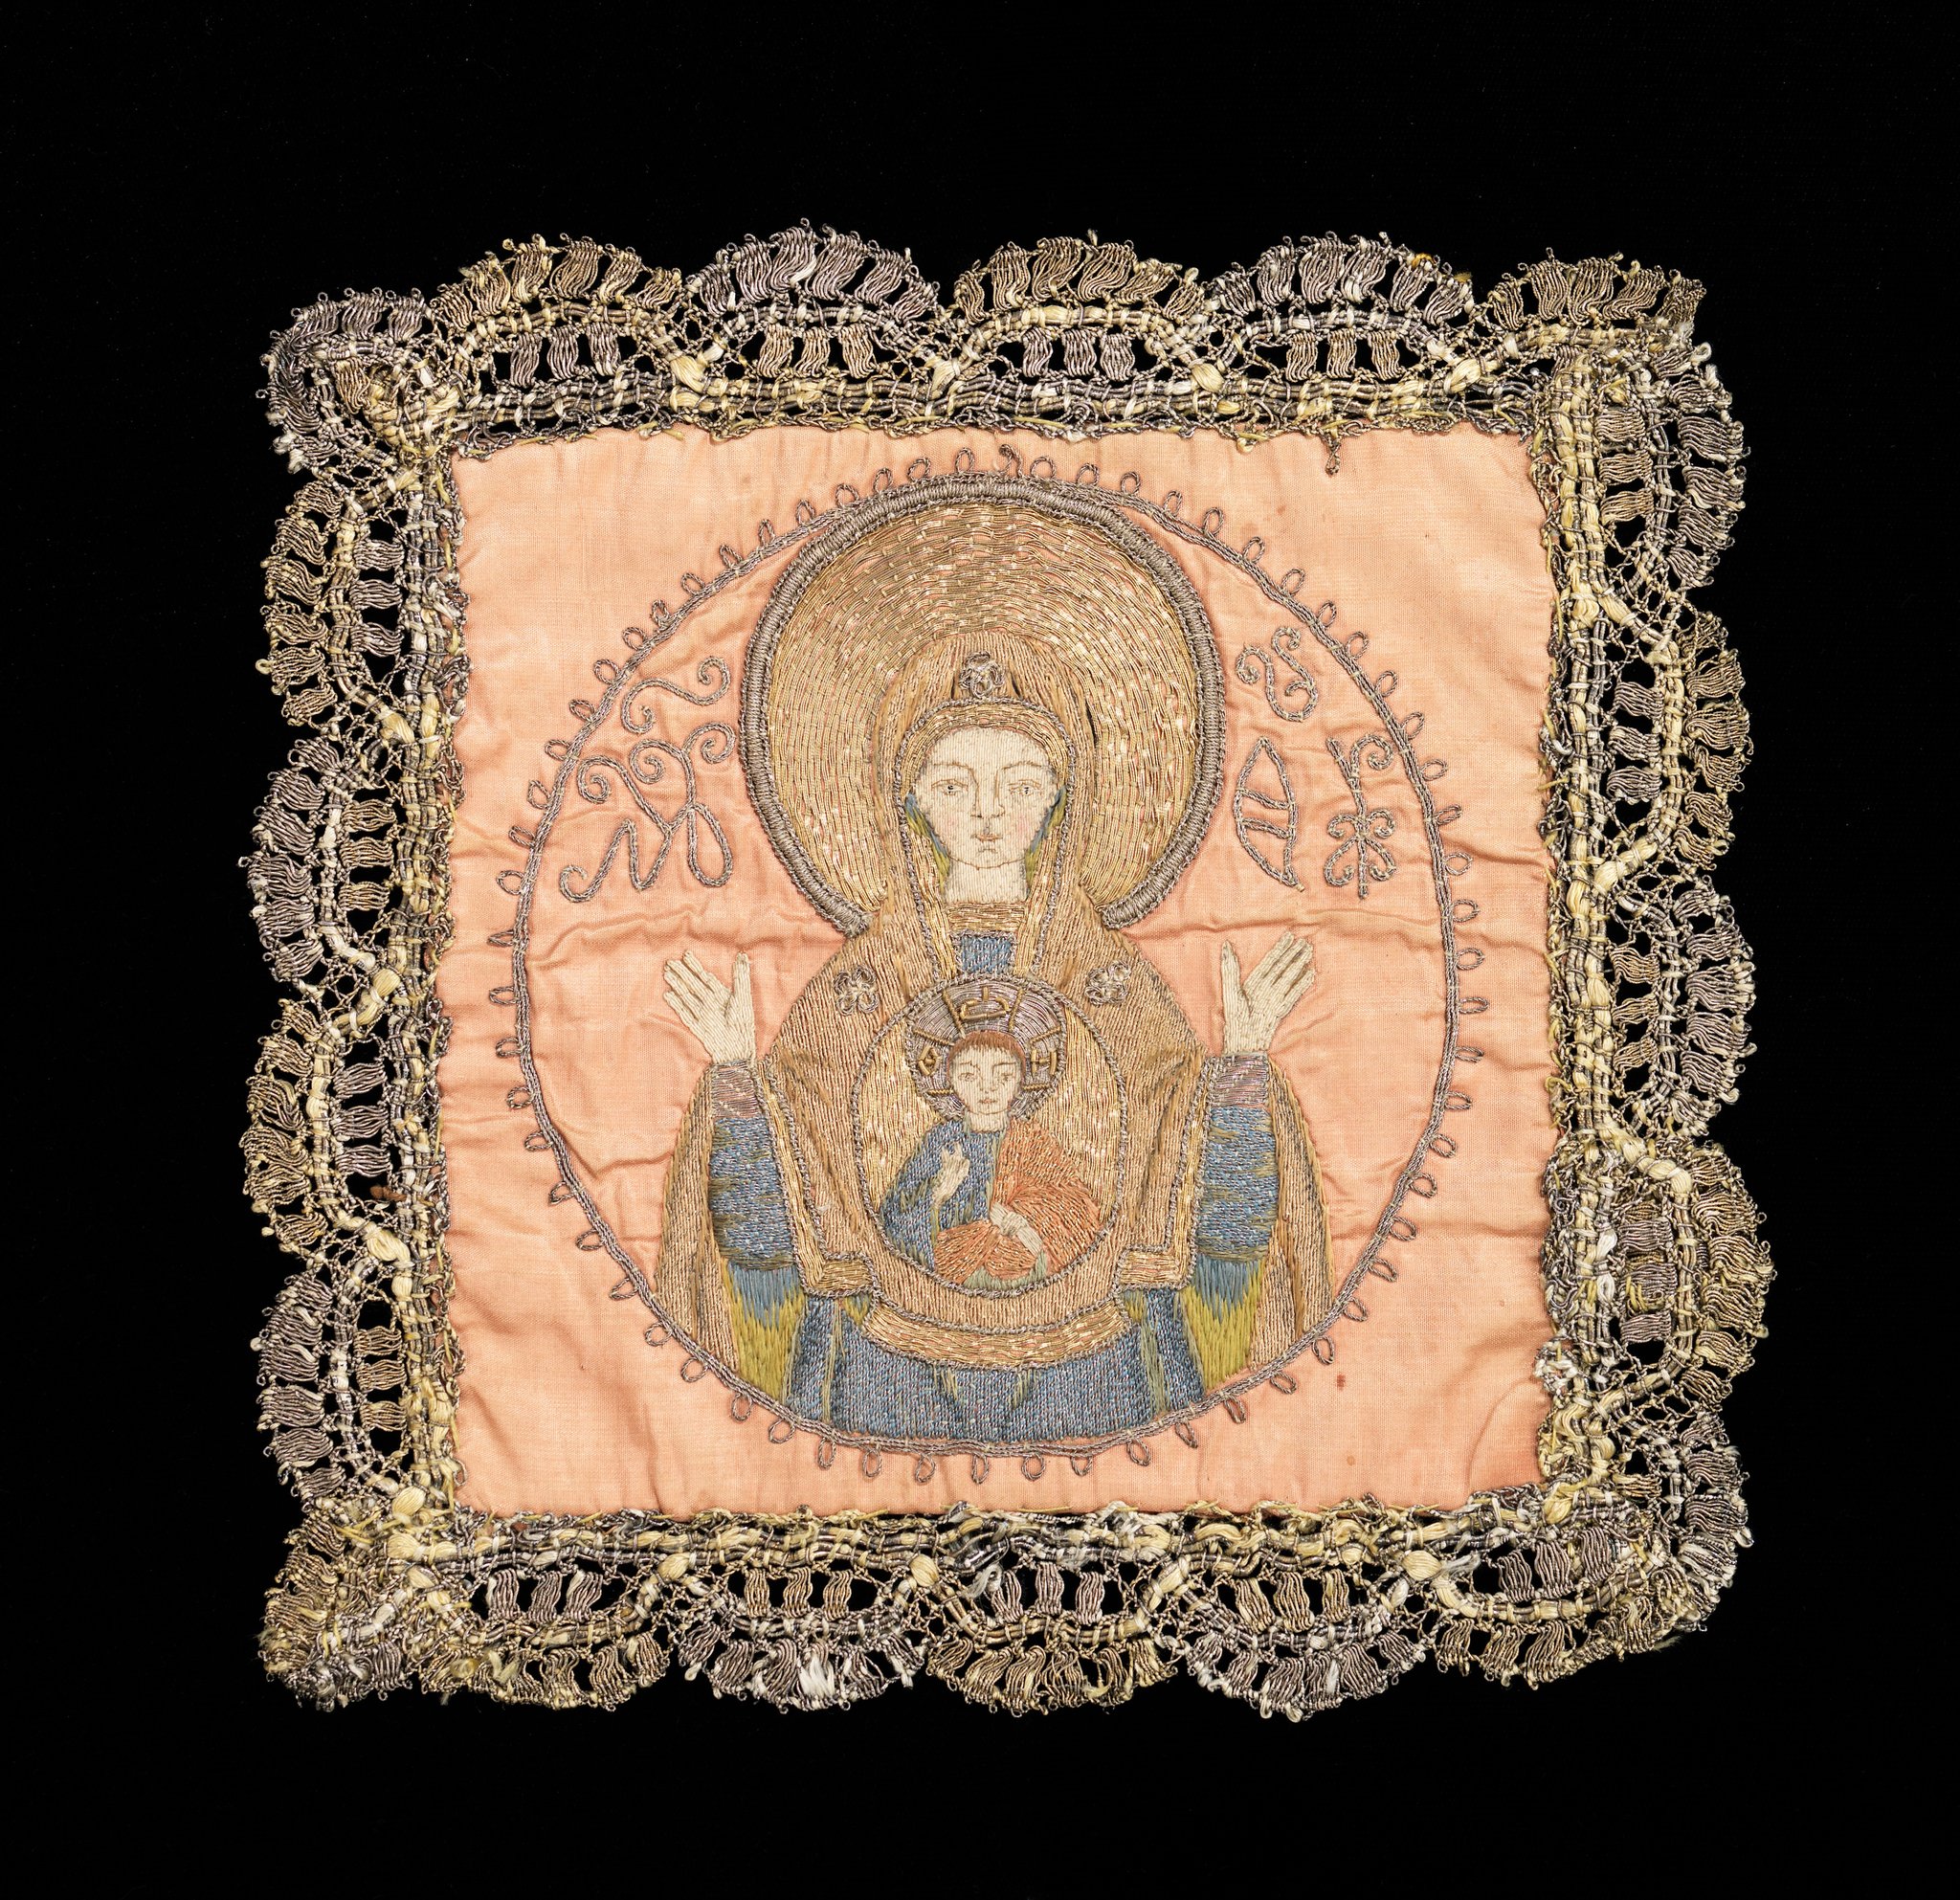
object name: paten cover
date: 1501-1600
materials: cotton, metal, silk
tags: women